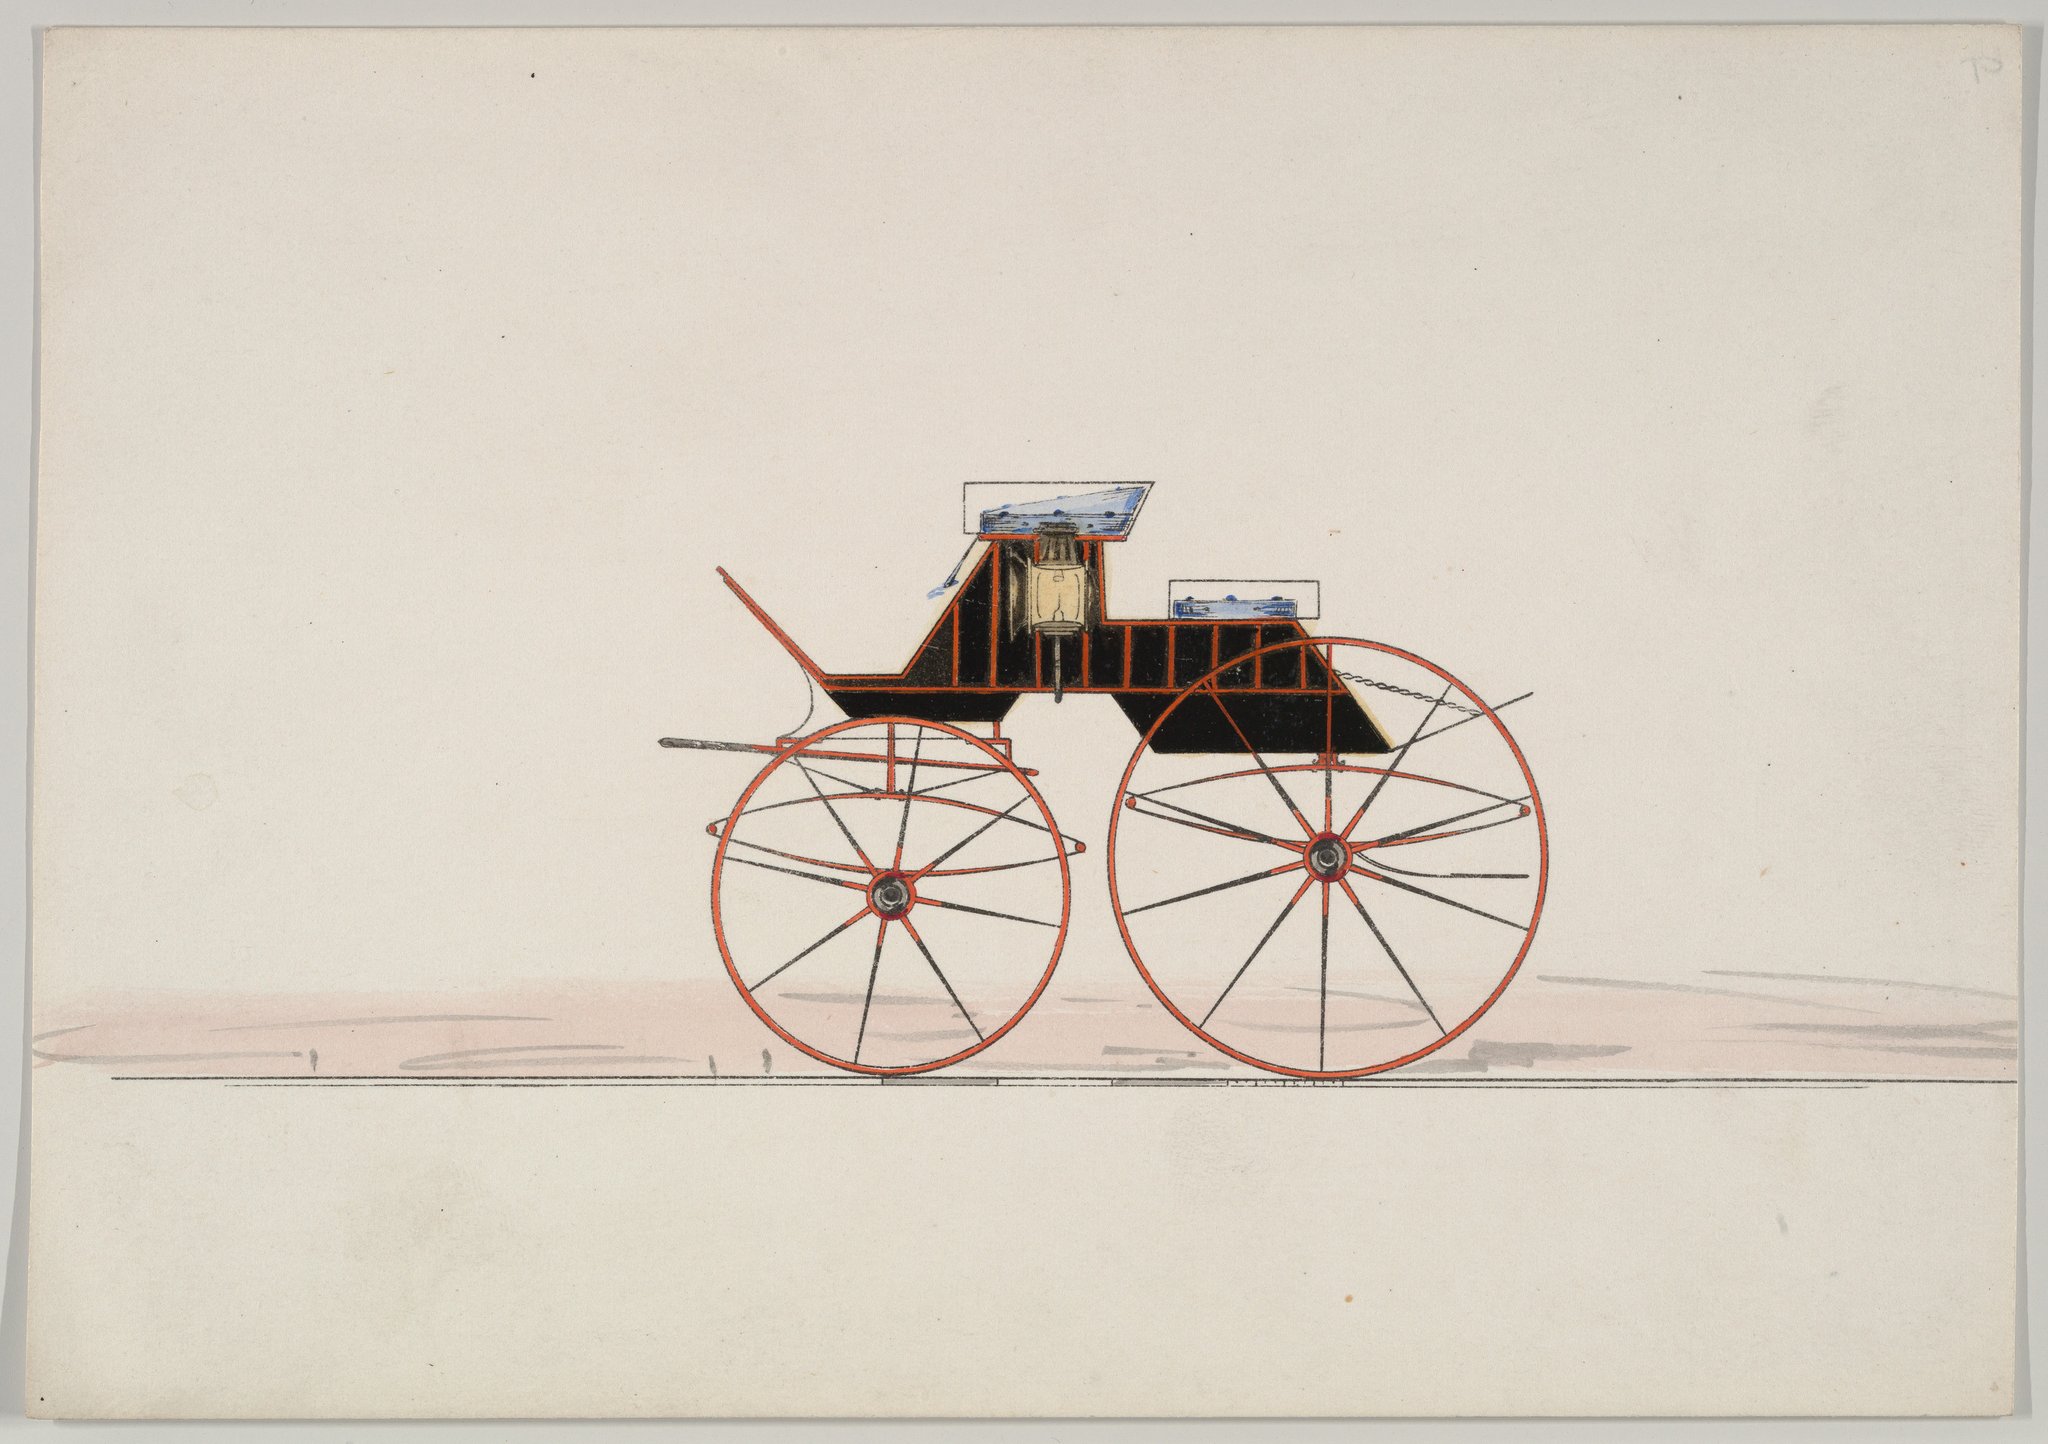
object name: drawing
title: Phaeton, no top (unnumbered)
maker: brewster & co.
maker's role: manufacturer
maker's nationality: american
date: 1850-1870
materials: gouache, gum arabic, watercolor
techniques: pen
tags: carriages